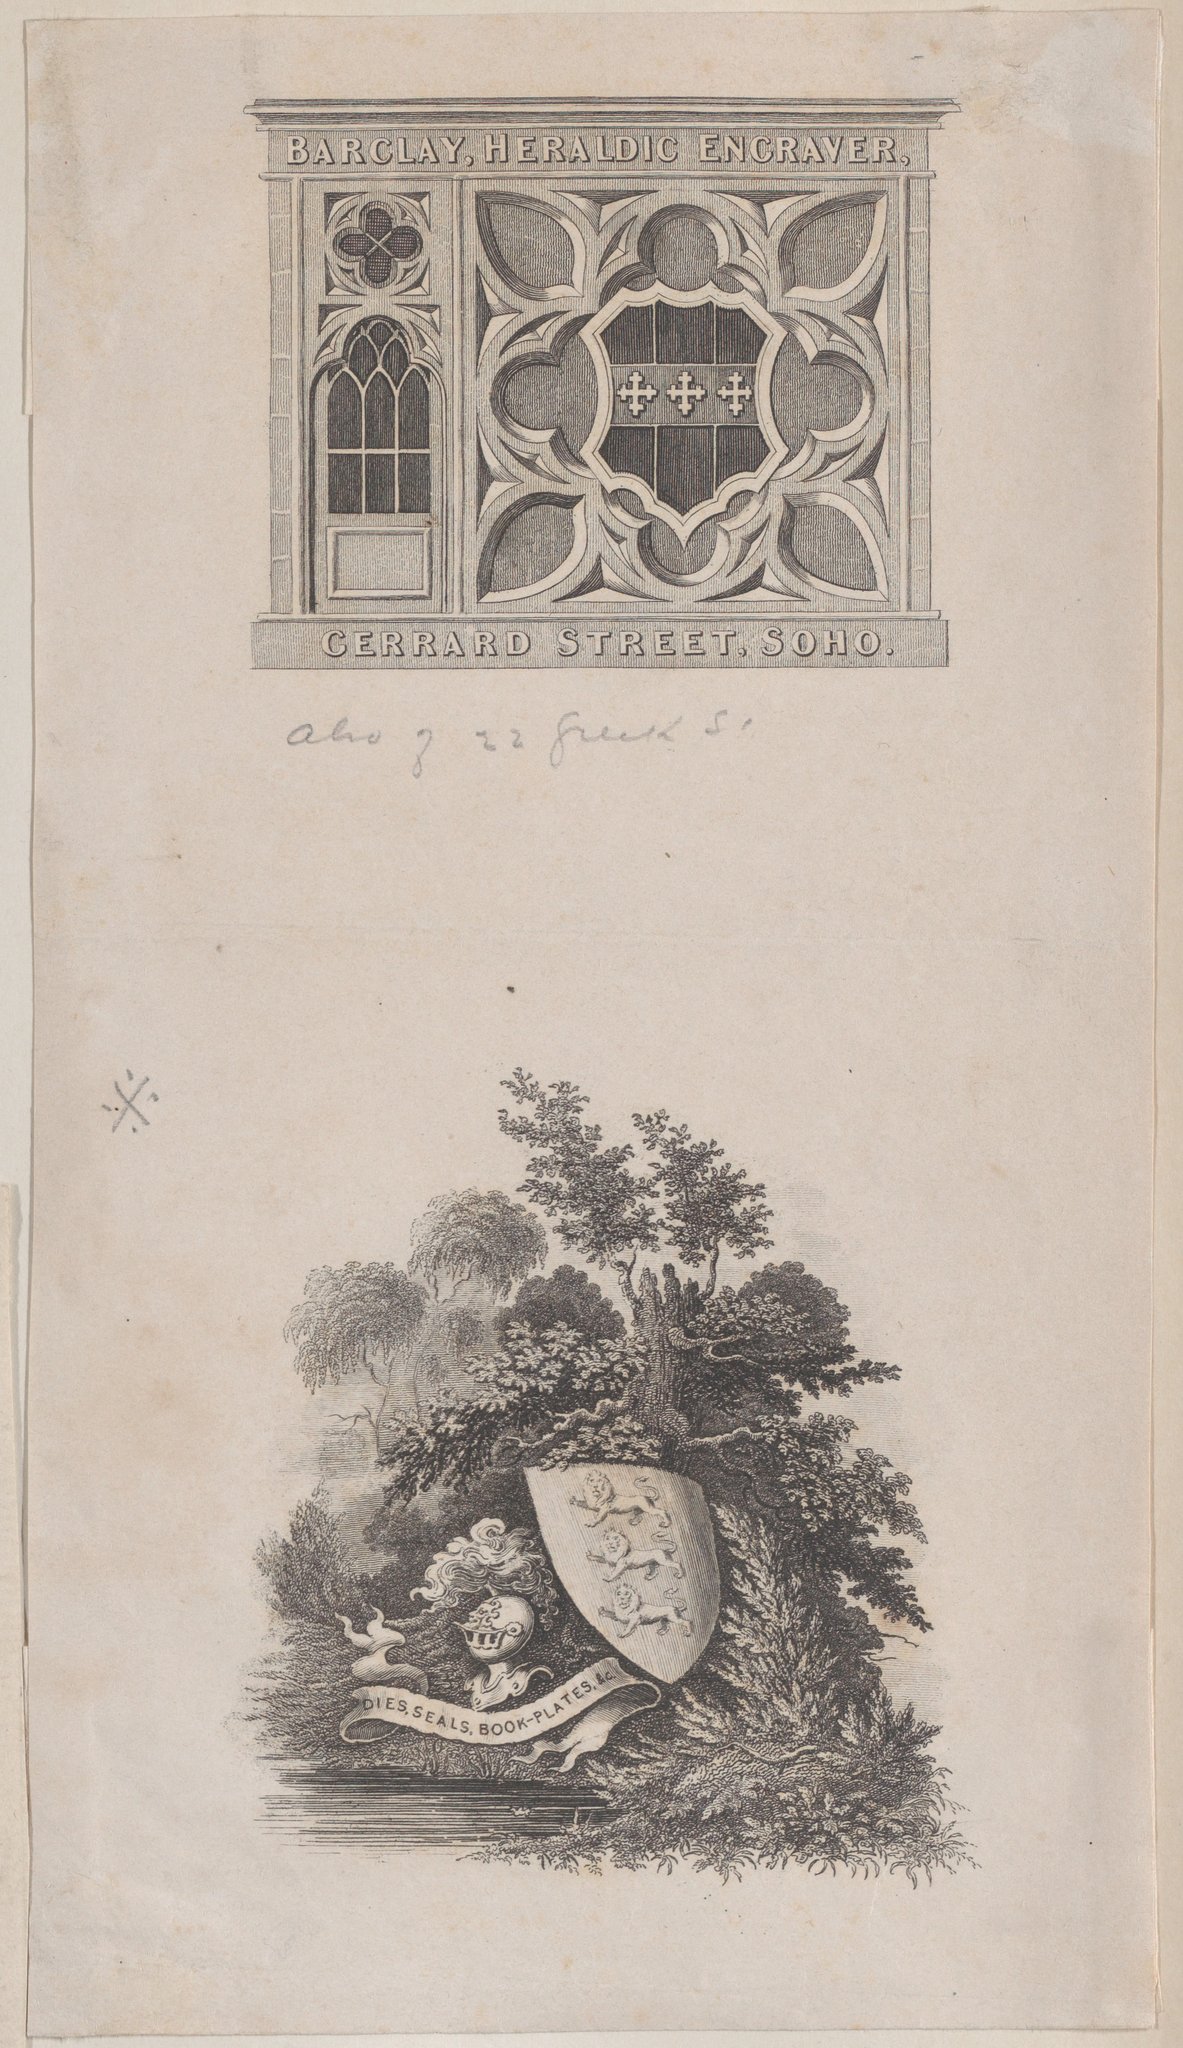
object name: print, trade card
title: Trade Card for Barclay, Heraldic Engraver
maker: anonymous, british, 19th century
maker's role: artist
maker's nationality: british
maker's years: 1800-1900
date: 1801-1900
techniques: engraving